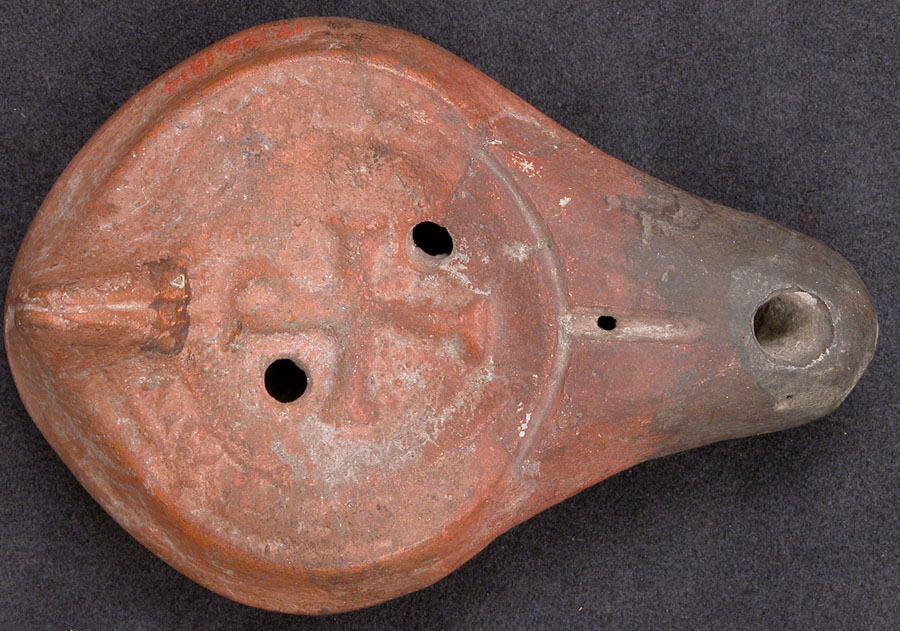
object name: lamp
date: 401-600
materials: earthenware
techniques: molding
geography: egypt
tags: cross